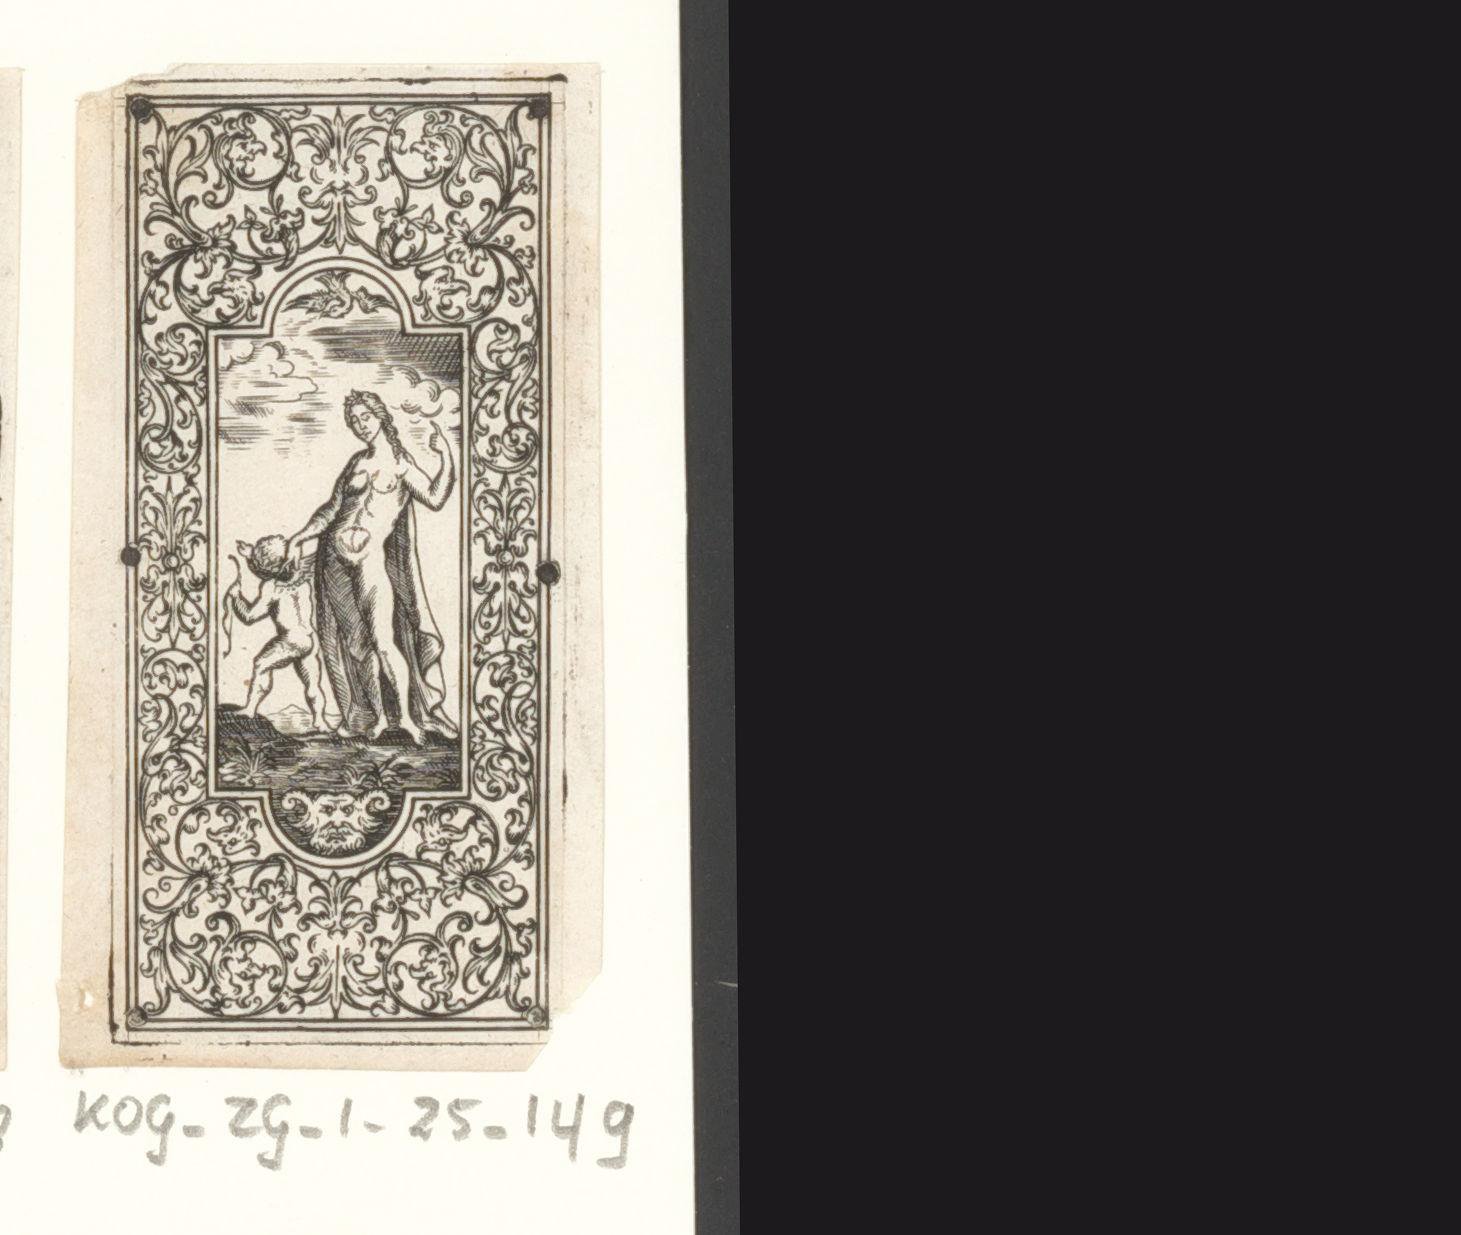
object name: ornament print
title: Venus en Amor in ornamentele omlijsting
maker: Anonymous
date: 1600-1699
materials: paper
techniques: engraving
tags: (story of) venus (aphrodite)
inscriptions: collector's mark: Lugt 963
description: Onderwerpsrubrieken binnen de Atlas Zeden en Gewoonten: Zeden en Gewoonten in Engeren Zin, De Woning, Huisraad, Zilverwerk.